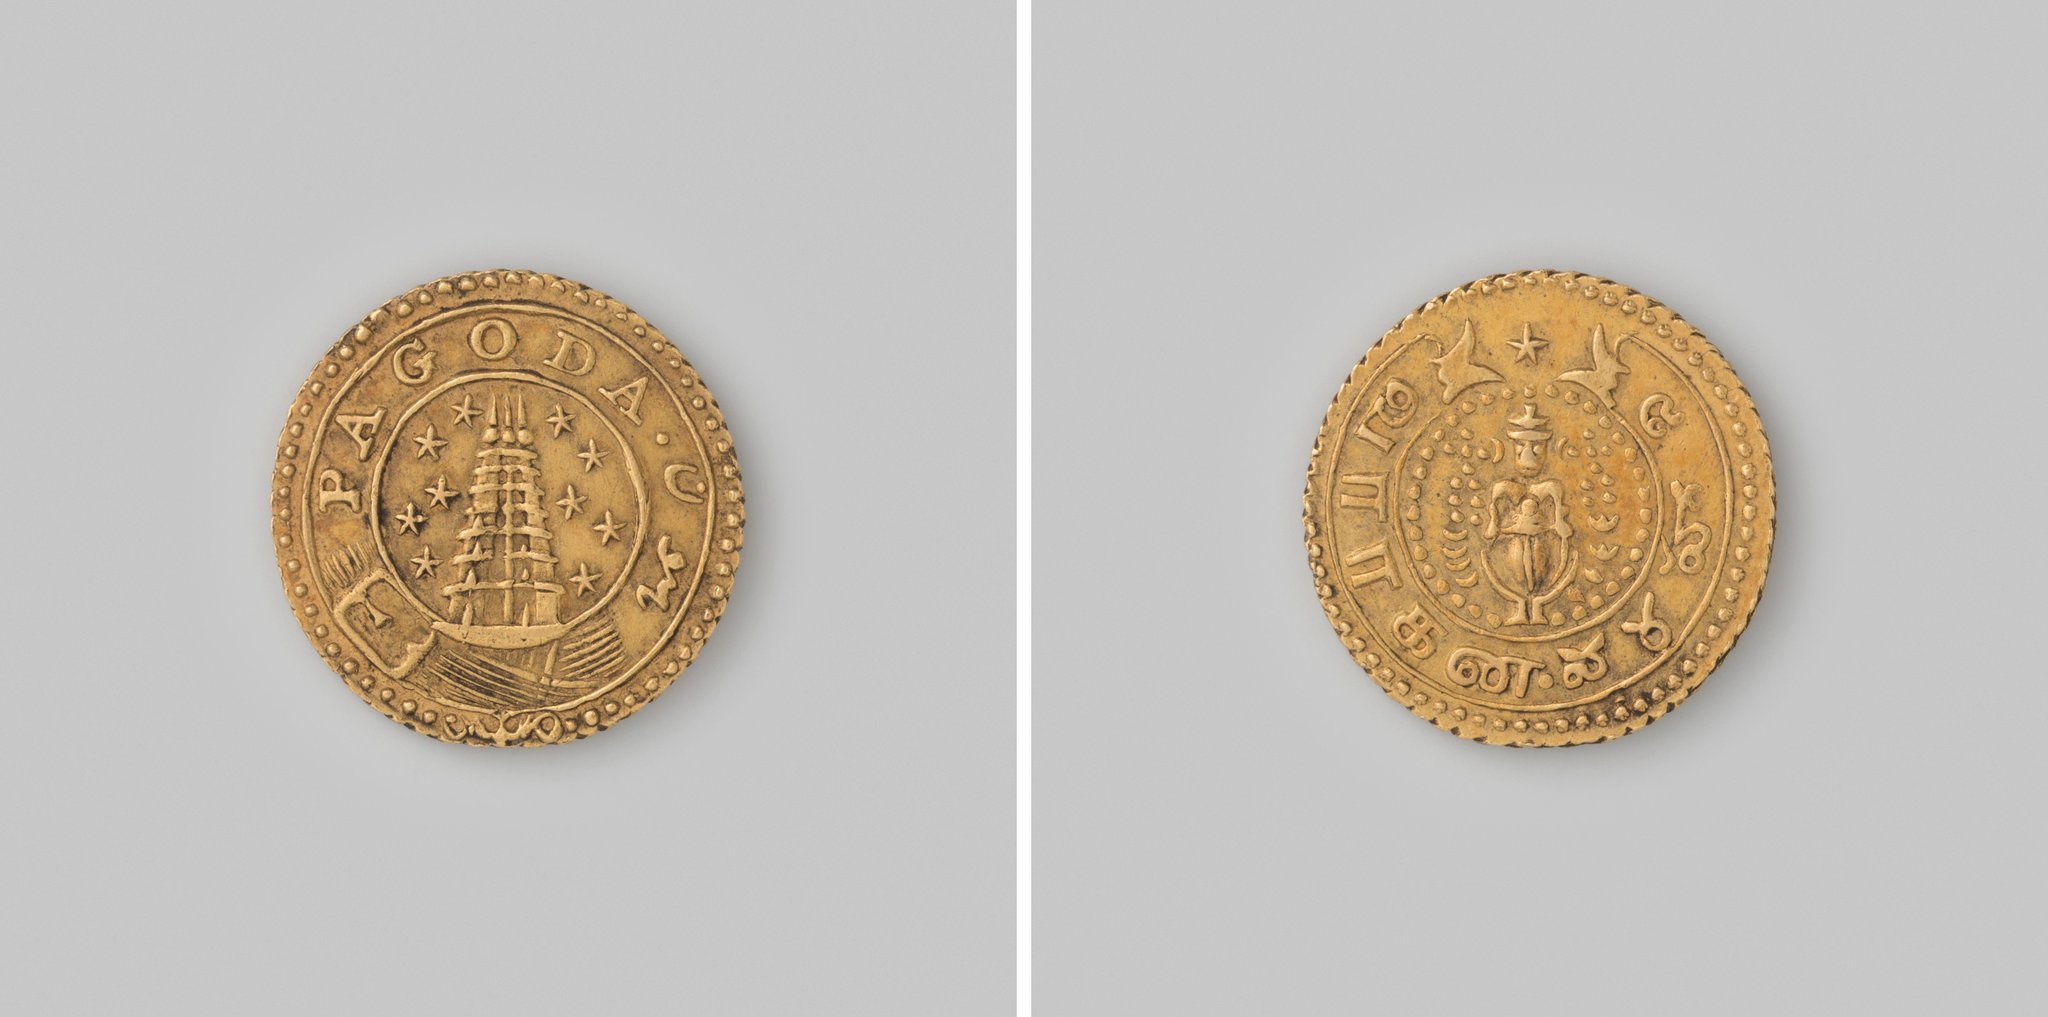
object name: coin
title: Madras, India, Engelse Oostindische Compagnie (EIC), pagoda, (1807)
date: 1807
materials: gold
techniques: striking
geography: chennai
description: Gouden munt. Voorzijde: binnen cirkel, gevormd door ceintuur met gesp tempelpoort, waaromheen sterren. Op gesp waarde-aanduiding in het Engels: pagoda, en in Arabische lettertekens. Keerzijde: binnen cirkel, gevormd door lint, waarop waarde-aanduiding in het Tamil en in het Telugu, godheid ten halve lijve, staande, in een veld, bezaaid met korrels. Bovenaan, tussen uiteinden van het lint, een ster. Kabelrand.